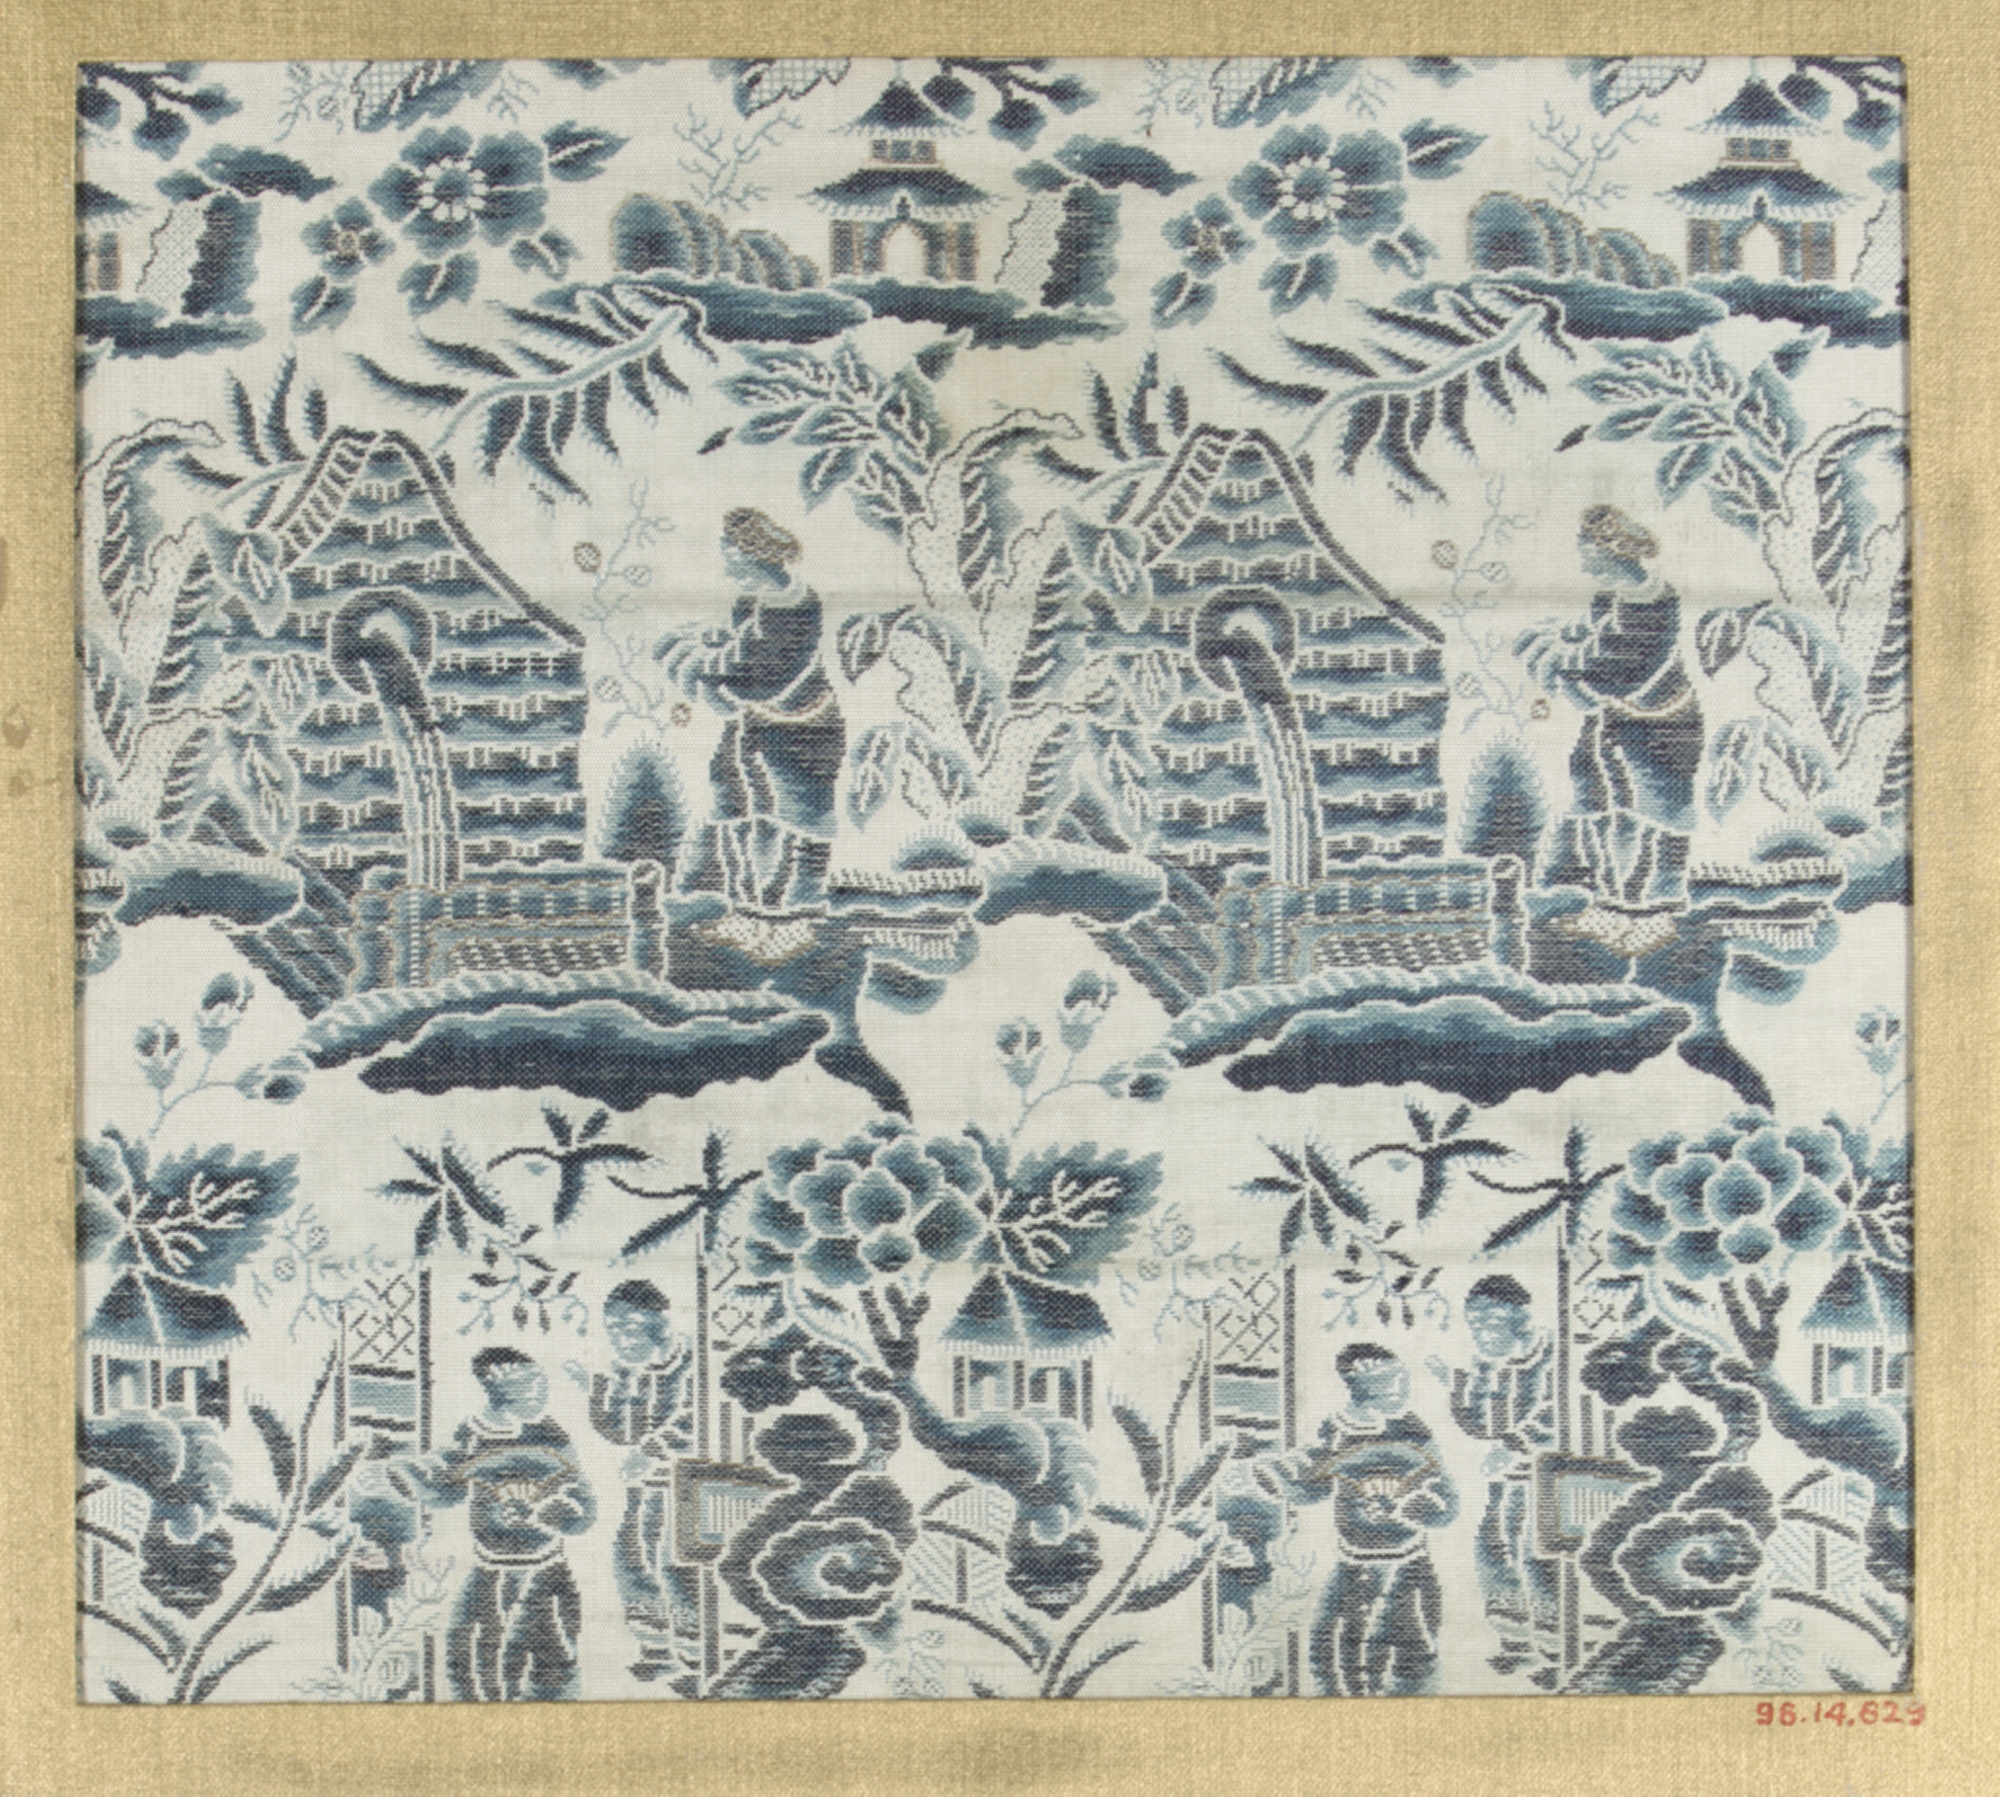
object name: piece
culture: japanese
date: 1701-1900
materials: silk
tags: men,women,flowers